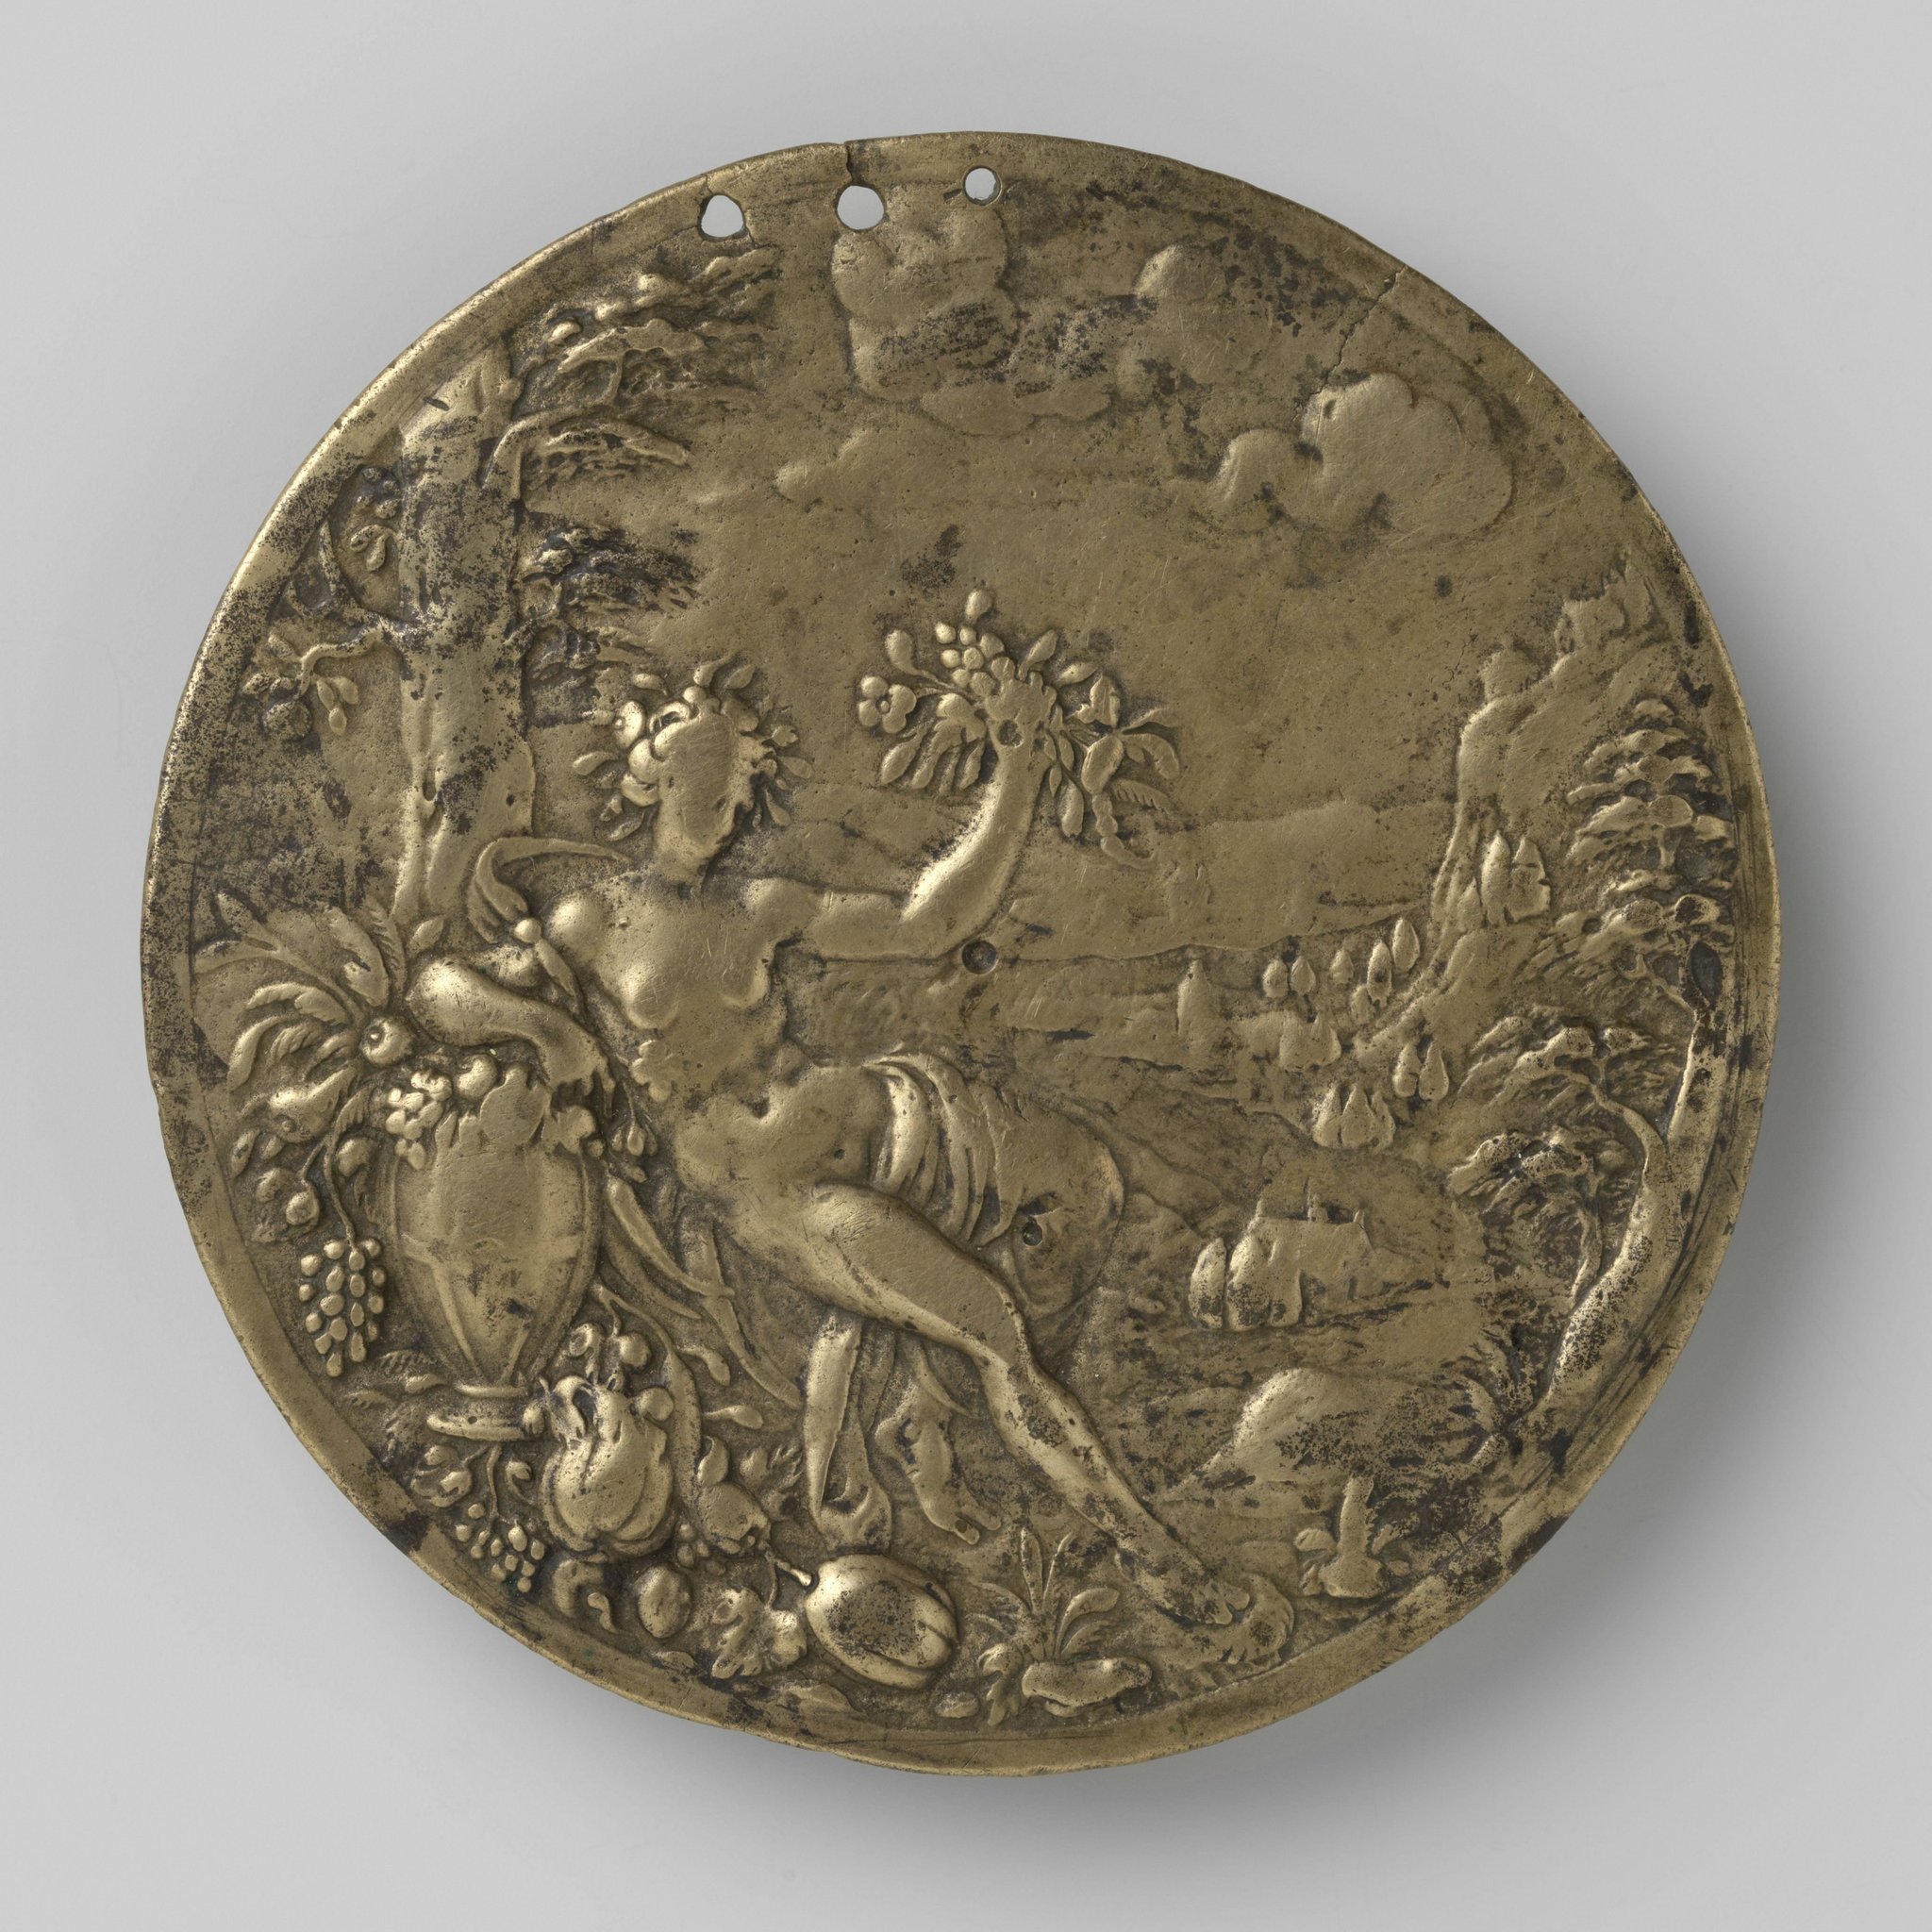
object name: plaque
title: Plaquette met Pomona of Ceres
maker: Anonymous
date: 1600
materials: bronze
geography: northern netherlands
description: Aarde. Ronde bronzen plaquette, omgeven door een vlakke rand. De naakte, zinnebeeldige vrouwenfiguur is gezeten ter linker zijde, het hoofd omkranst en een bos bloemen in haar omhoog geheven linkerhand; haar rechterarm steunt op een vaas met vruchten, achter haar een boomstam. Een rivierlandschap op de achtergrond met bomen en bergen in het verschiet.